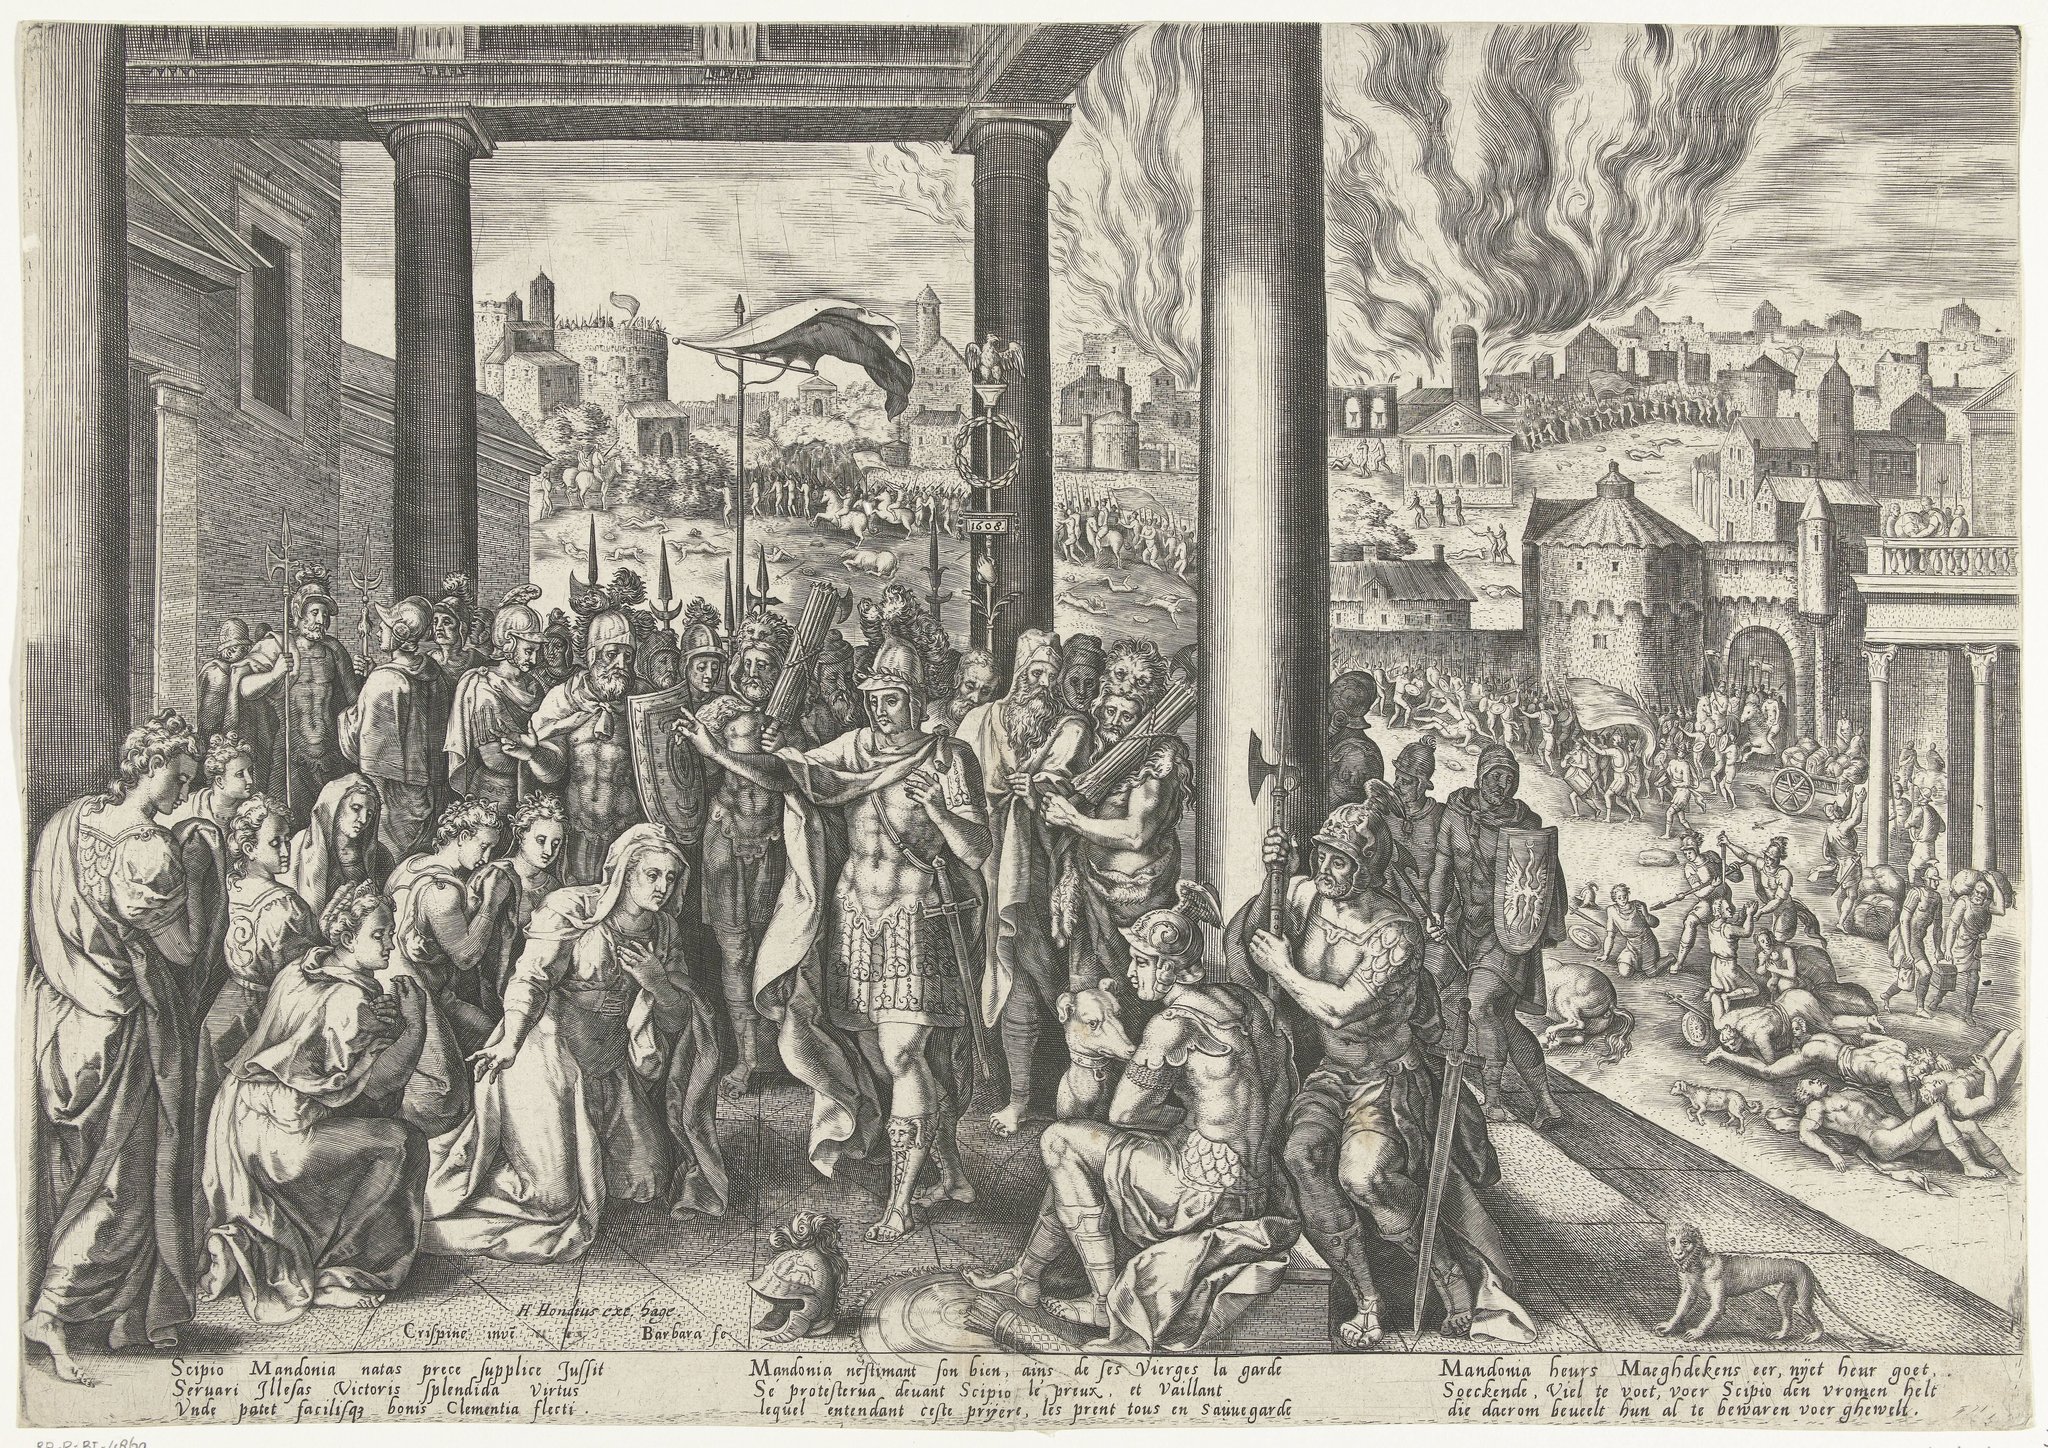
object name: print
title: The Continence of Scipio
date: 1597-1650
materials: paper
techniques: engraving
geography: the hague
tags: the continence of scipio: he restores a captive woman to her bridegroom allucius, who kneels before him; the ransom offered by the bride's parents is given to allucius as a wedding-gift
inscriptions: collector's mark: Lugt 2228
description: After Scipio conquered Carthage, the general magnanimously returned a captured woman to her fiancée. Inscribed on the Roman standard in the centre is the date 1608. In that year, this print, engraved by Barbara van den Broeck twenty years earlier, was republished by Hendrick Hondius. Like her, Hondius too had fled from Antwerp to the Northern Netherlands. Other copper plates by Van den Broeck were also reprinted by Hondius.